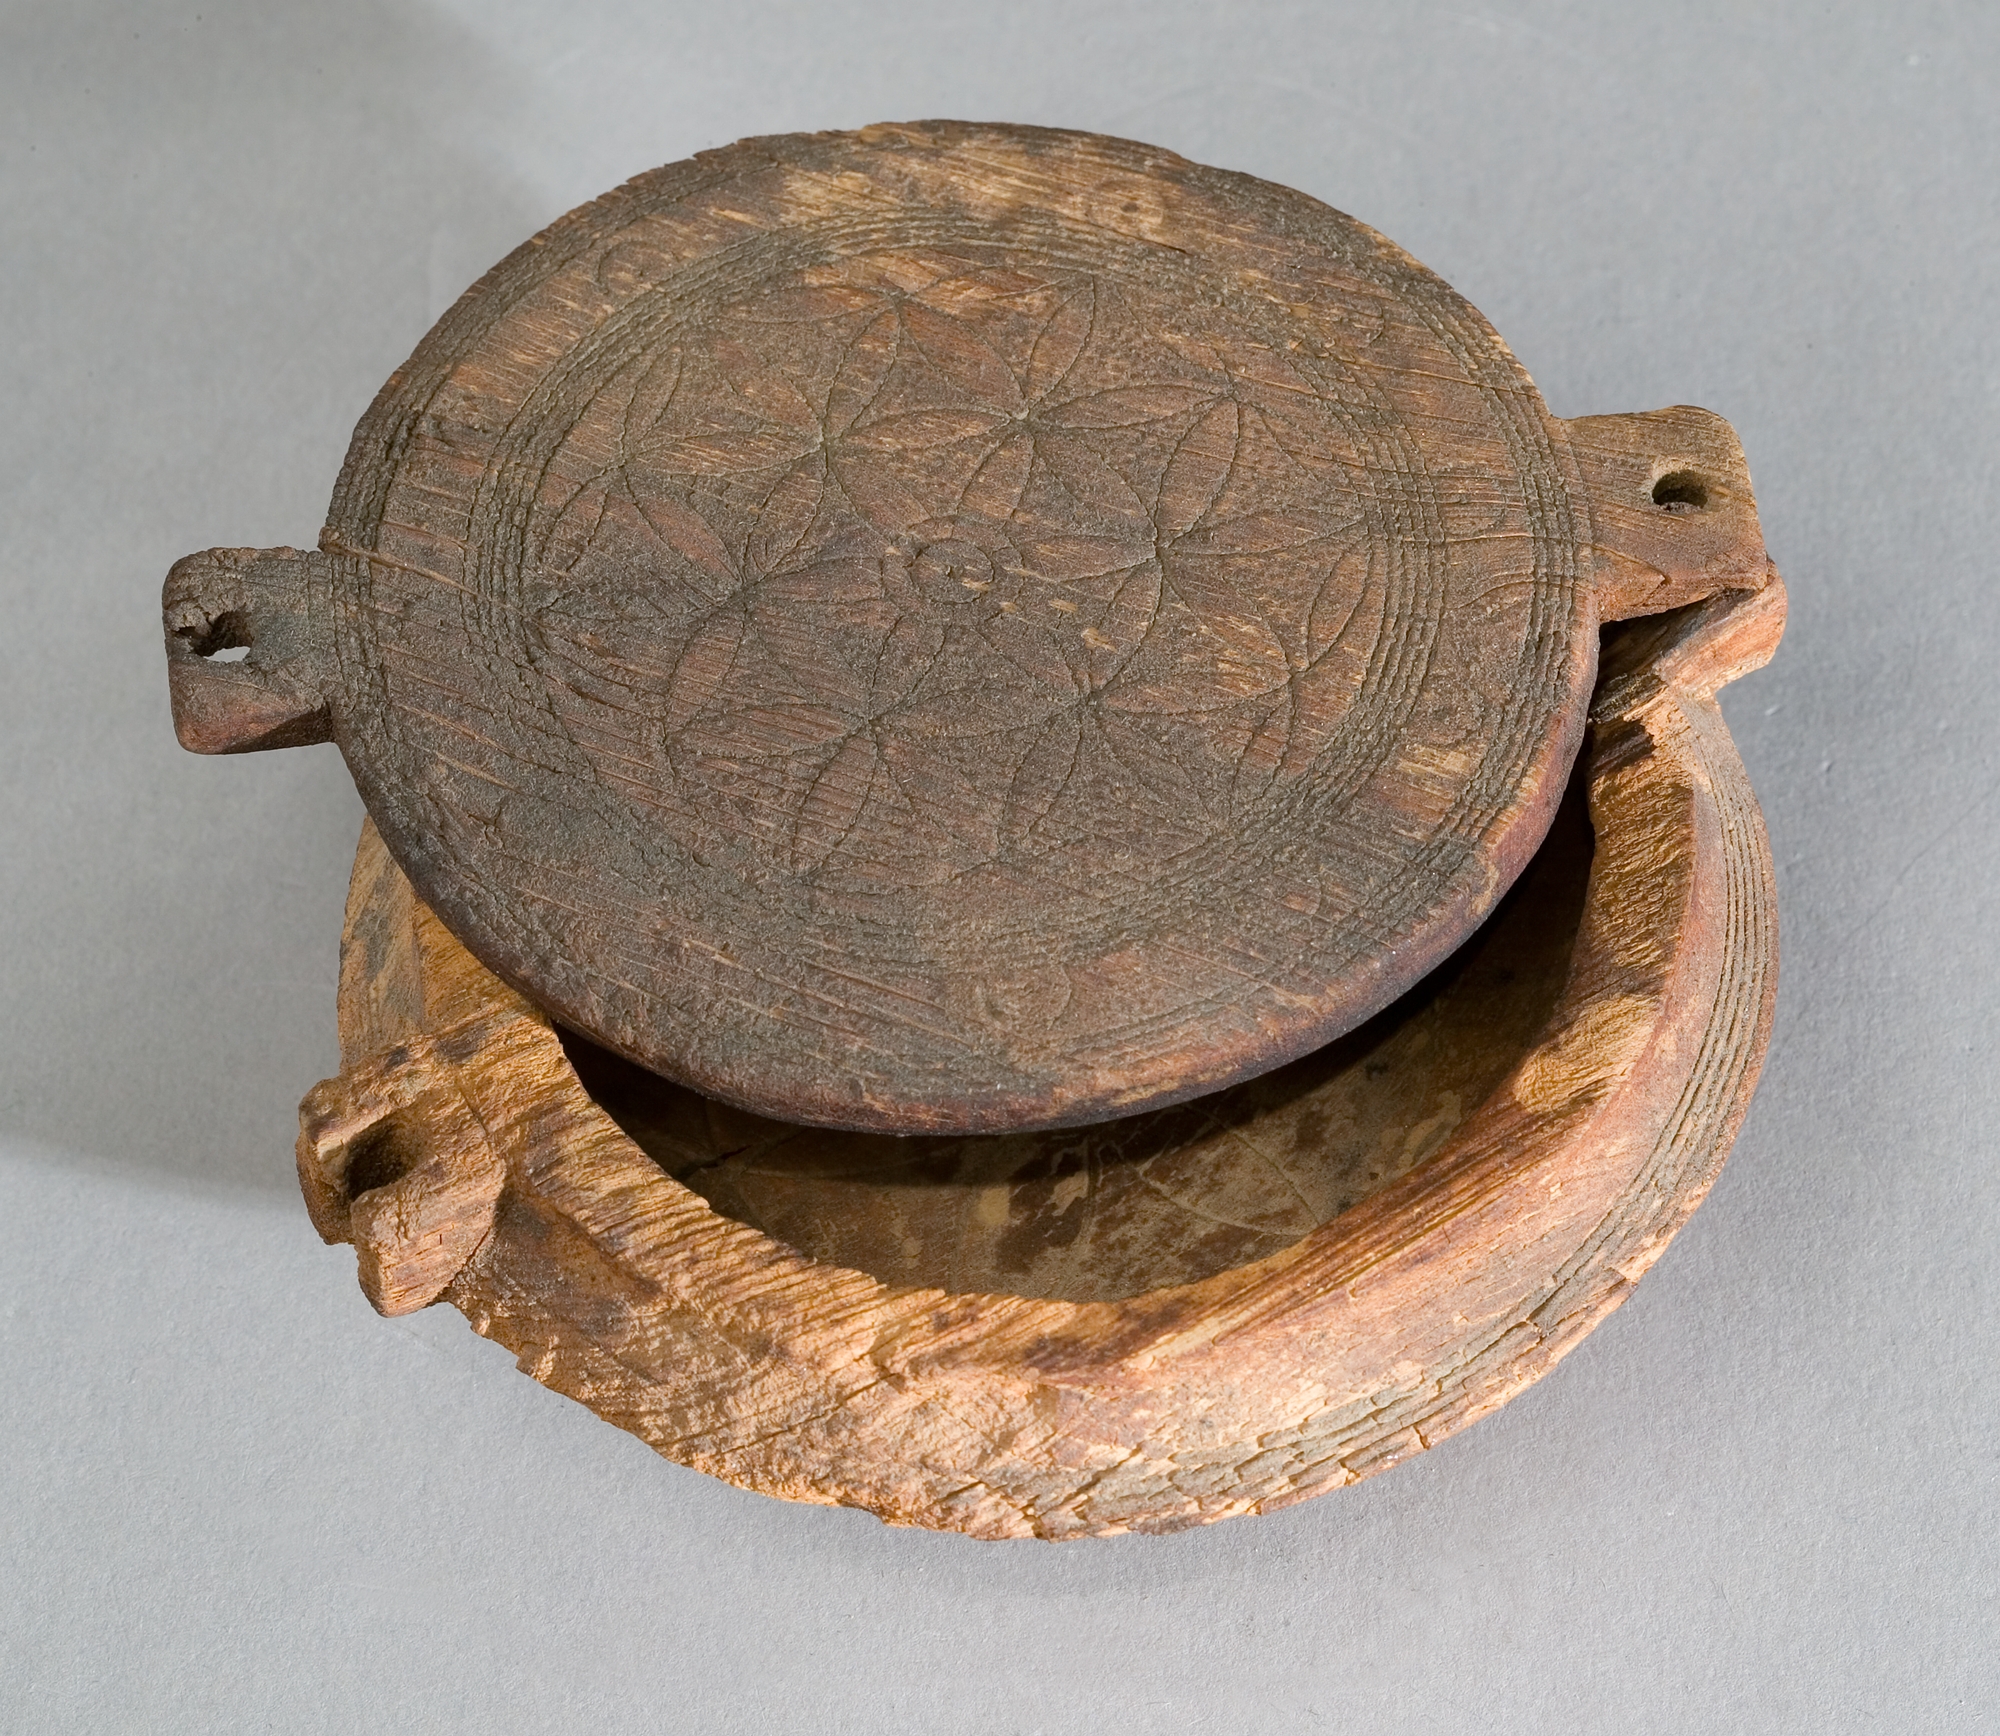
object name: cosmetic box, swivel lid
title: Circular Cosmetic Box with a Swivel Lid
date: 1492-1473 BCE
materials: wood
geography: egypt